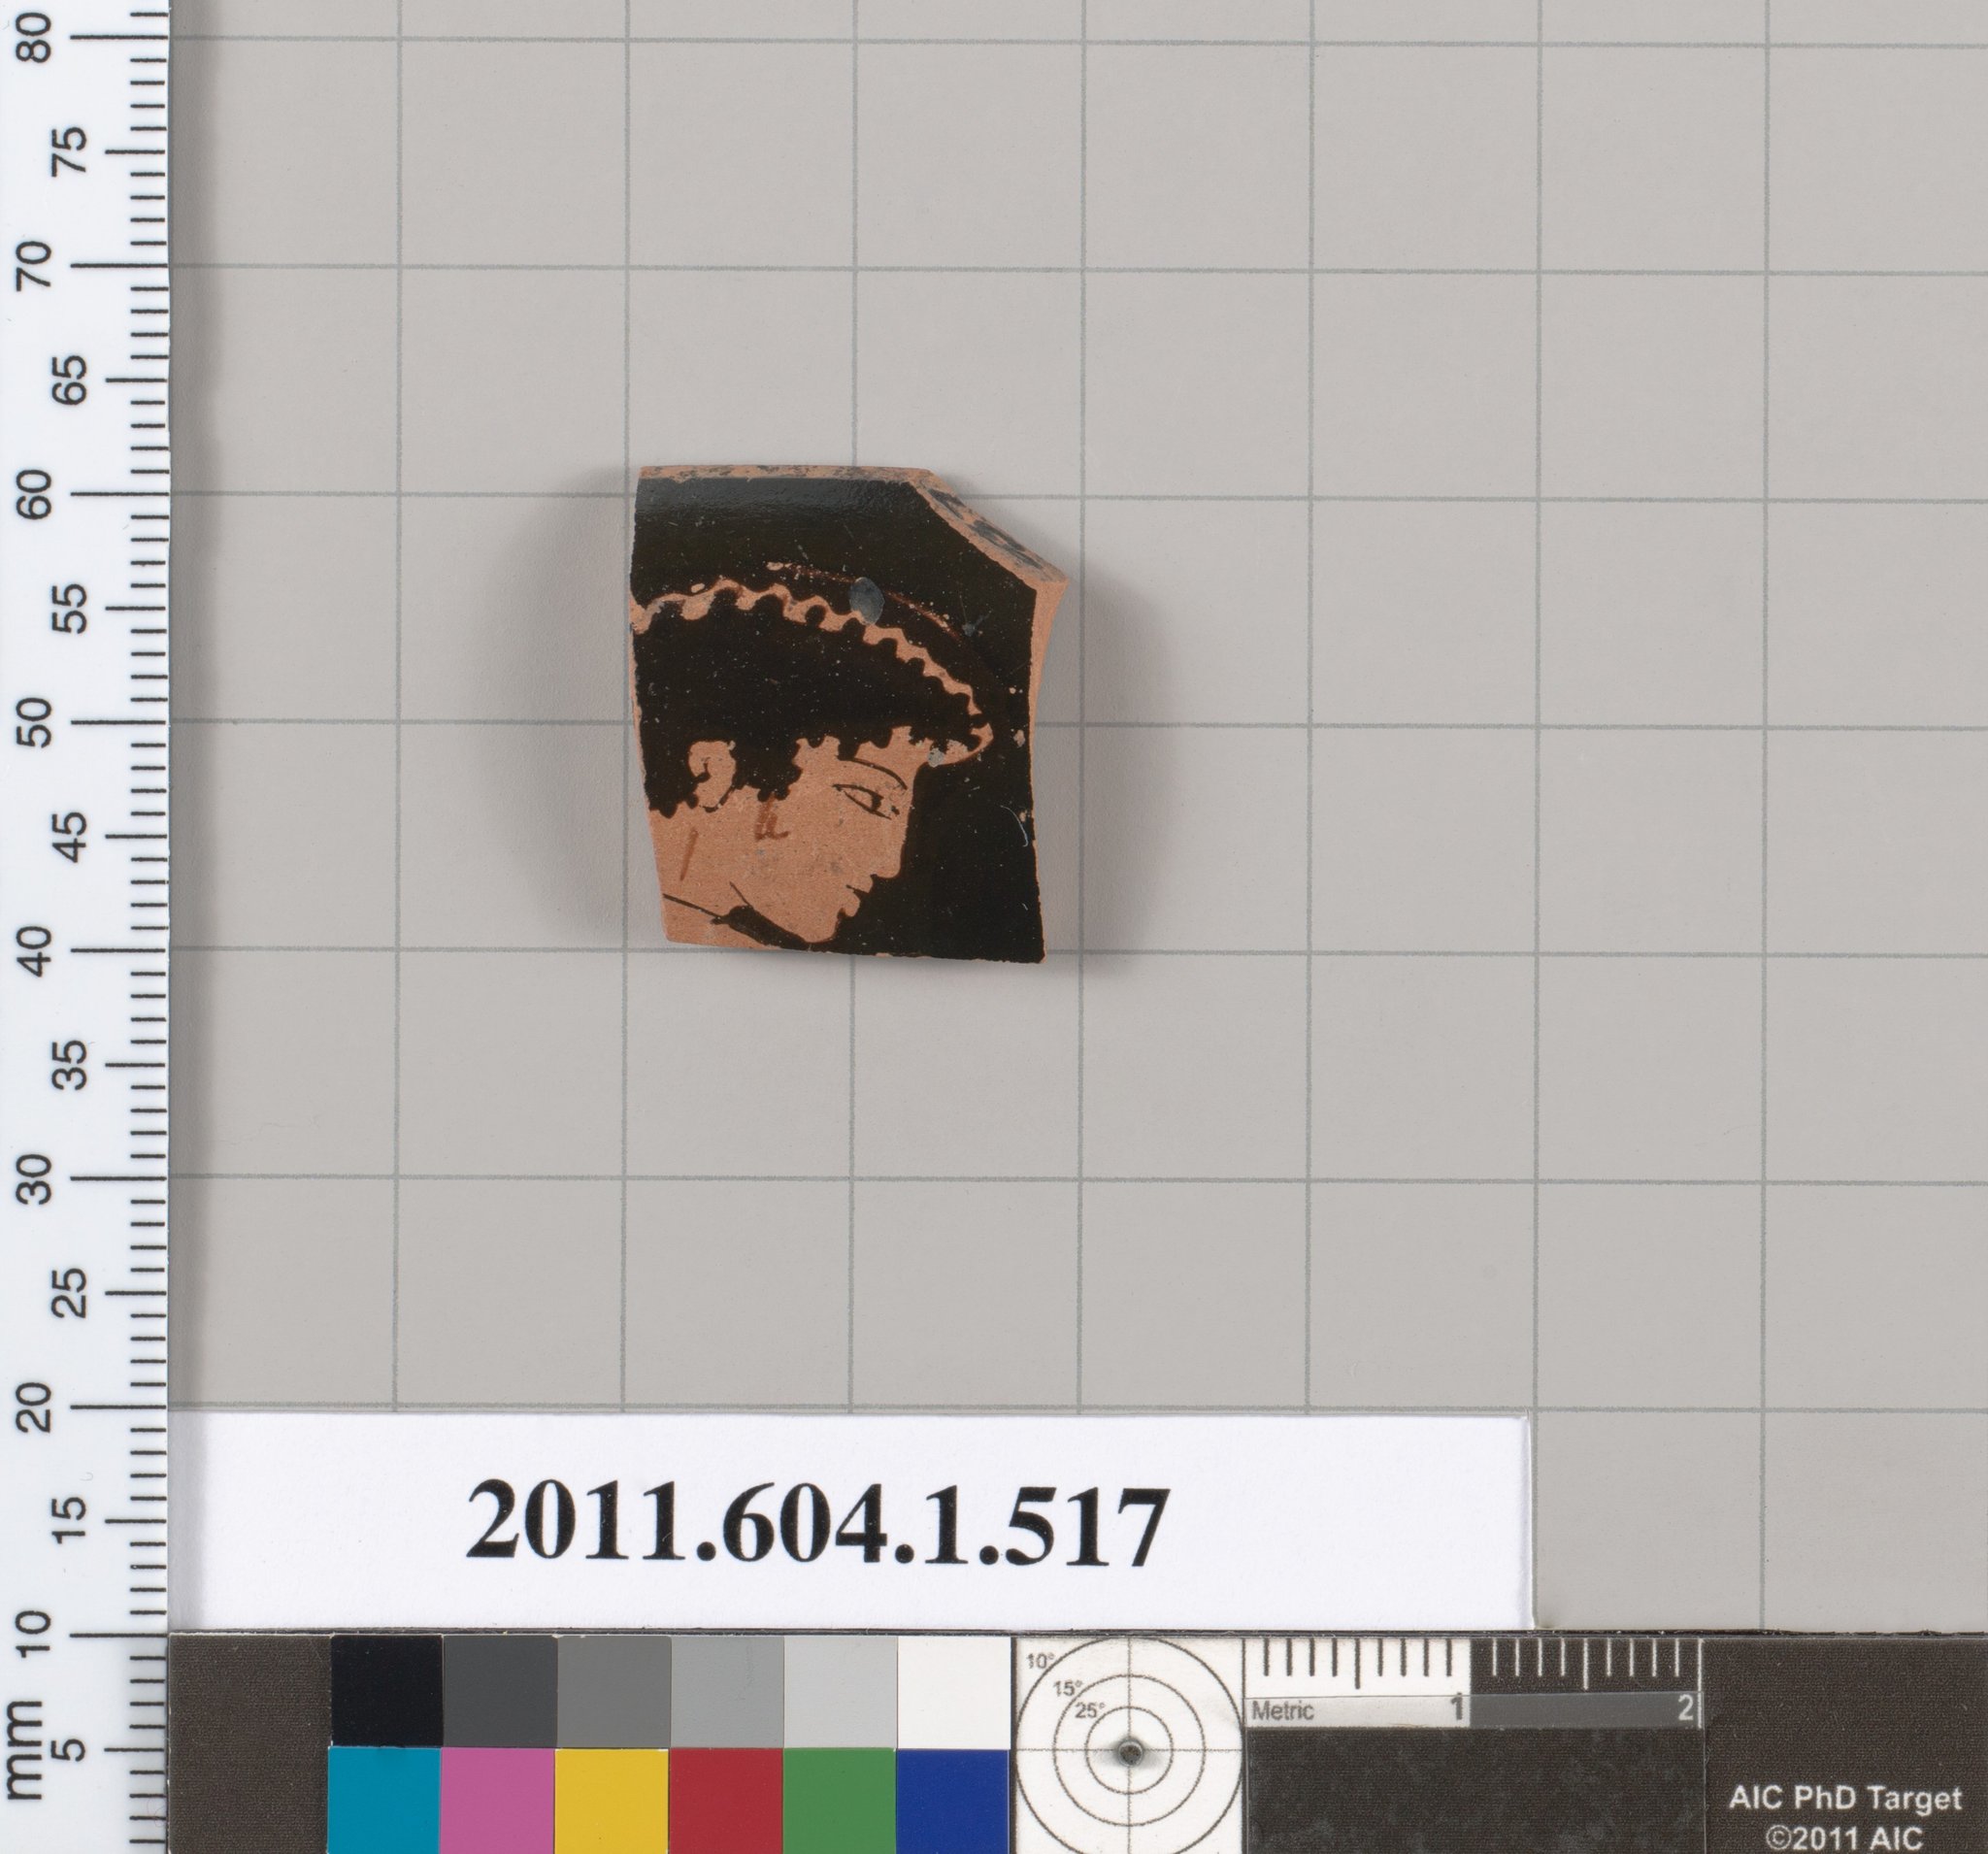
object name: kylix fragment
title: Terracotta rim fragment of a kylix (drinking cup)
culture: greek, attic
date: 490-480 BCE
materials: terracotta